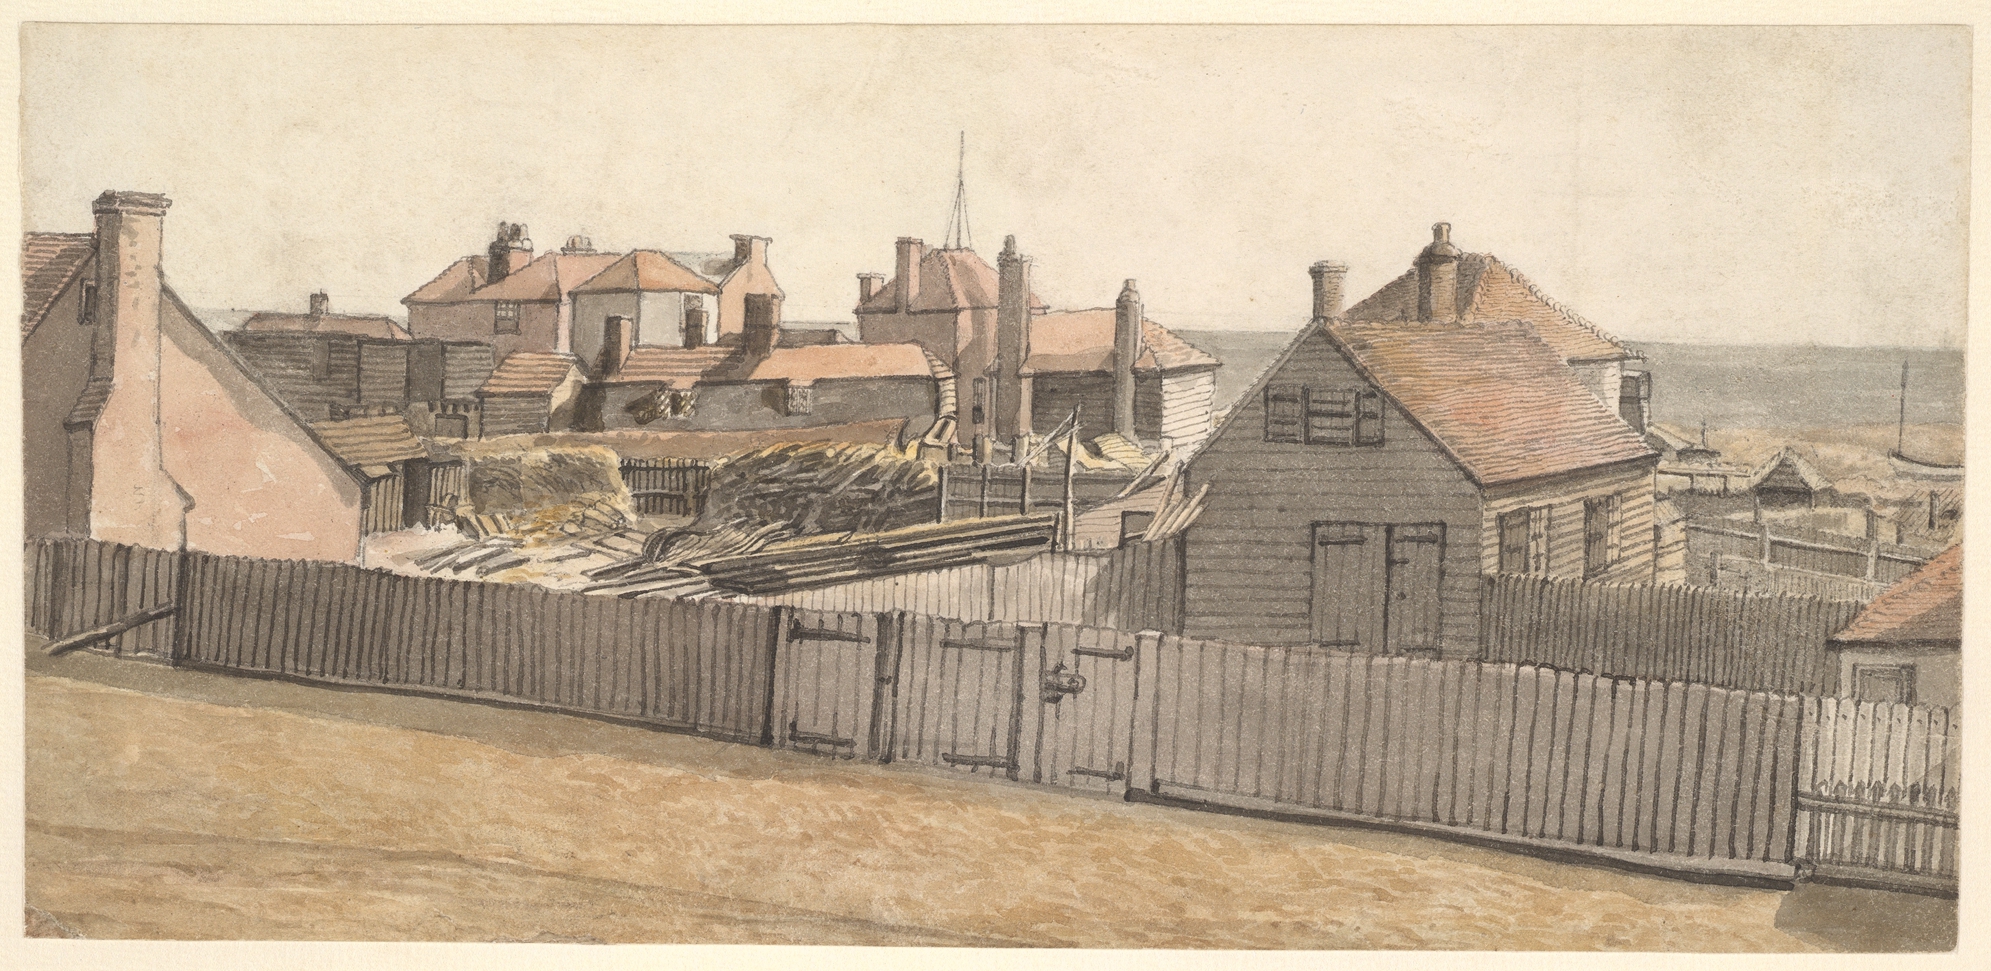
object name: drawing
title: Fishermen's cottages at Hastings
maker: william henry hunt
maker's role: artist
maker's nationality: british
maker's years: 1790-1864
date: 1815-1825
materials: watercolor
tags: houses,beaches